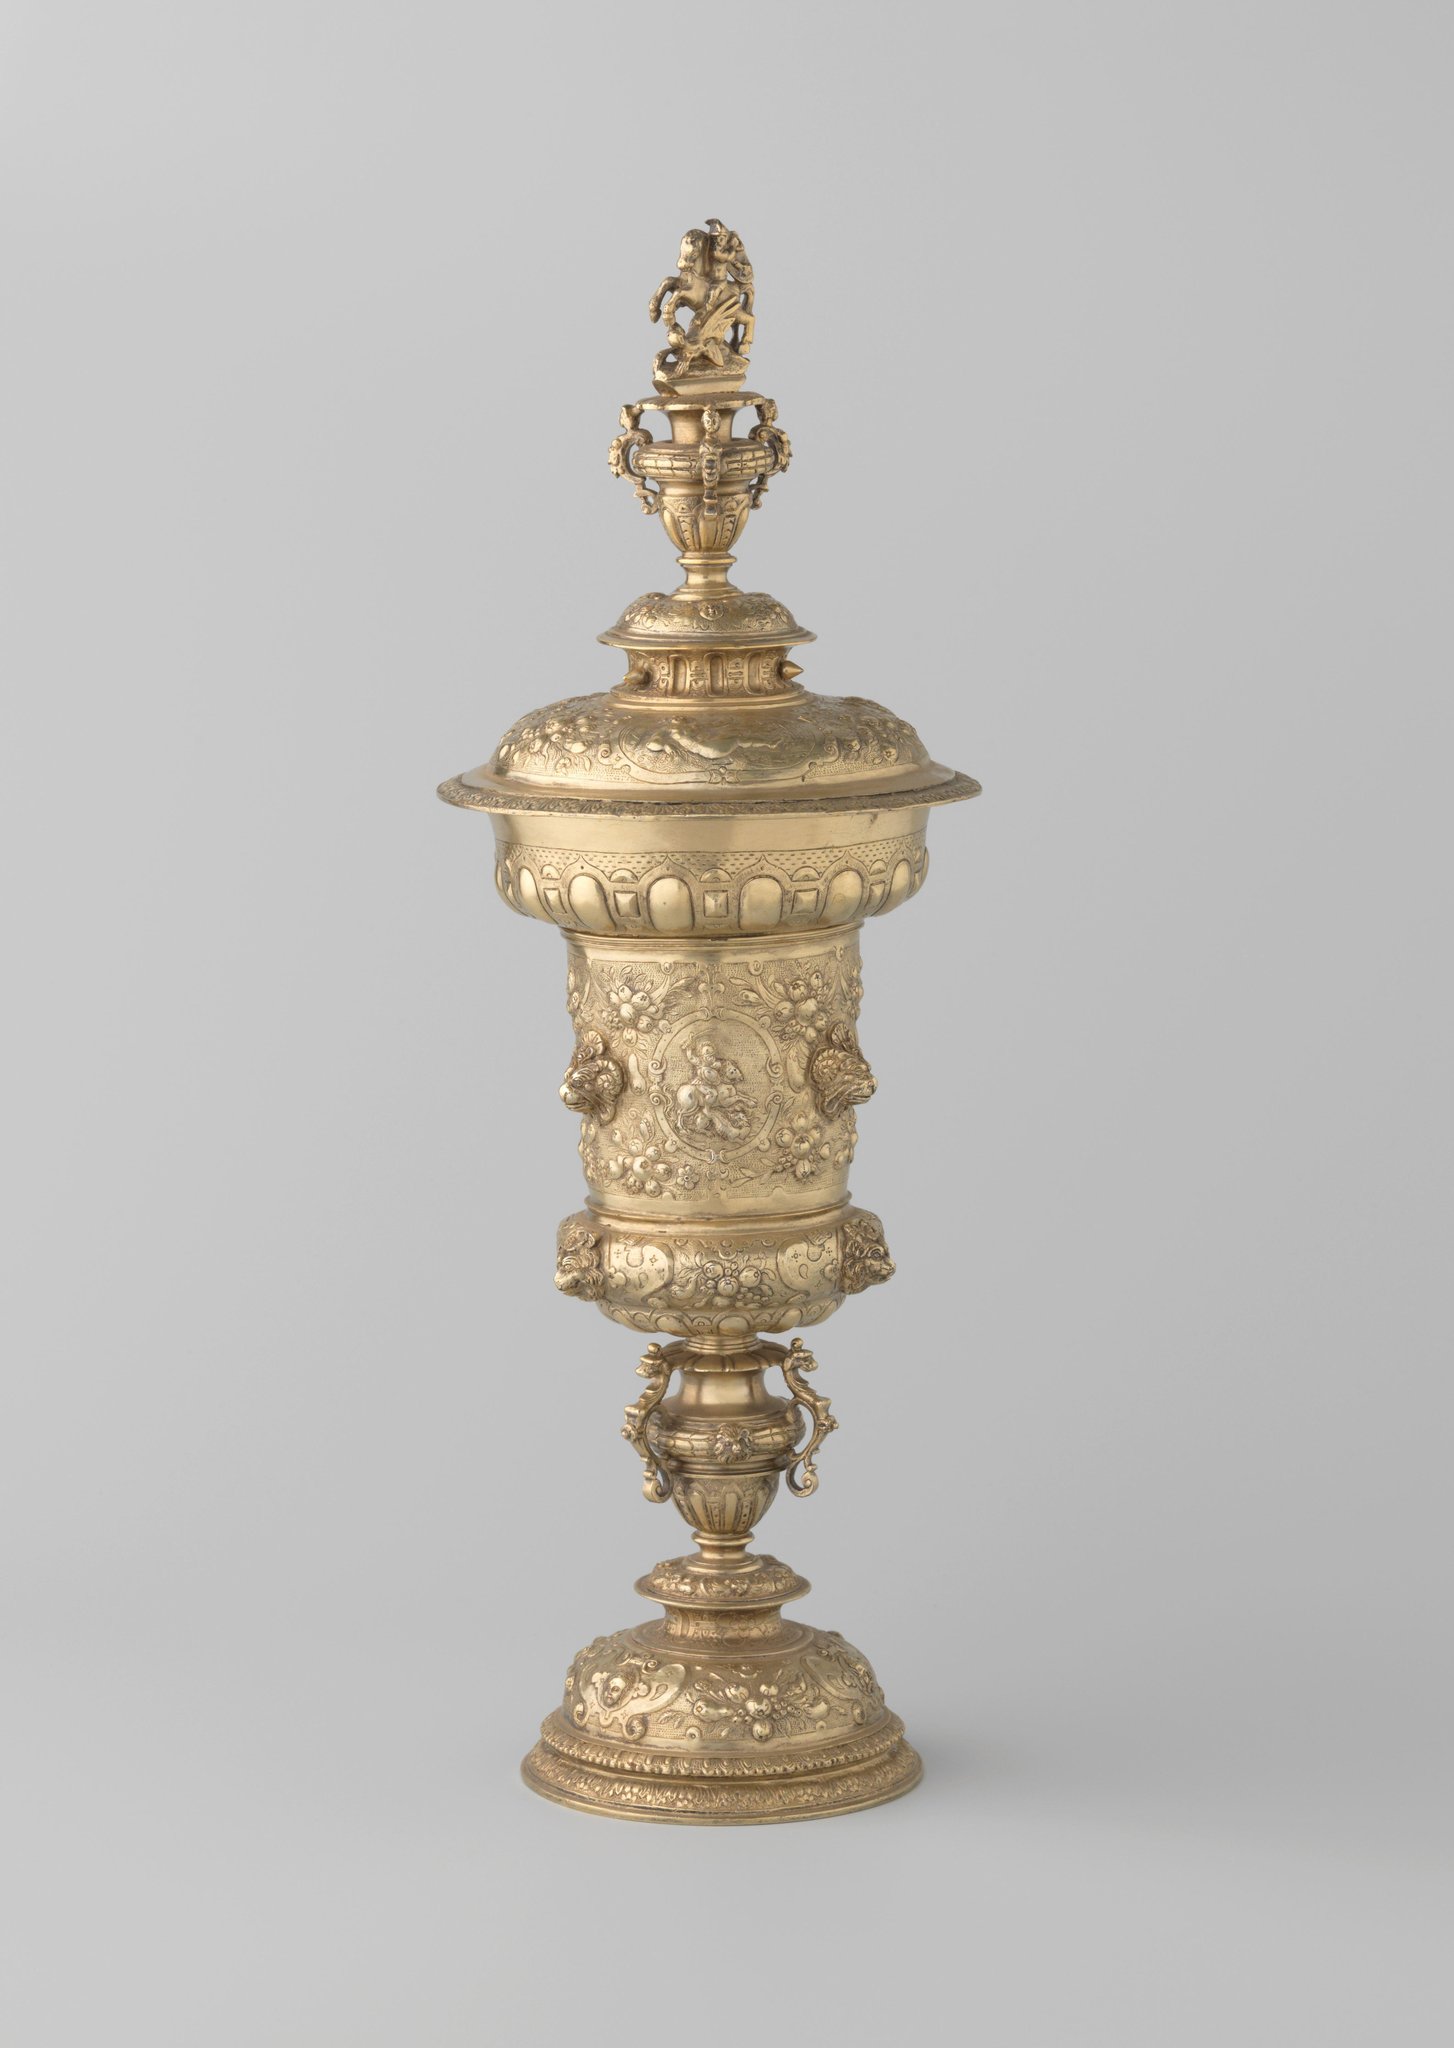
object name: lid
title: Galvanoplastische reproductie van het deksel van de beker van het St. Jorisgilde van Middelburg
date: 1881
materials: copper, silver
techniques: galvanoplasty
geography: london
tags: middelburg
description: Galvanoplastische reproductie van het deksel van de beker van het St. Jorisgilde van Middelburg. De cuppa, op een balustervormige stam, met drie wapenschilden en leeuwenkoppen; op het deksel vier medaillons met vrucht- en bloemornamenten en een figuur van St. Joris.